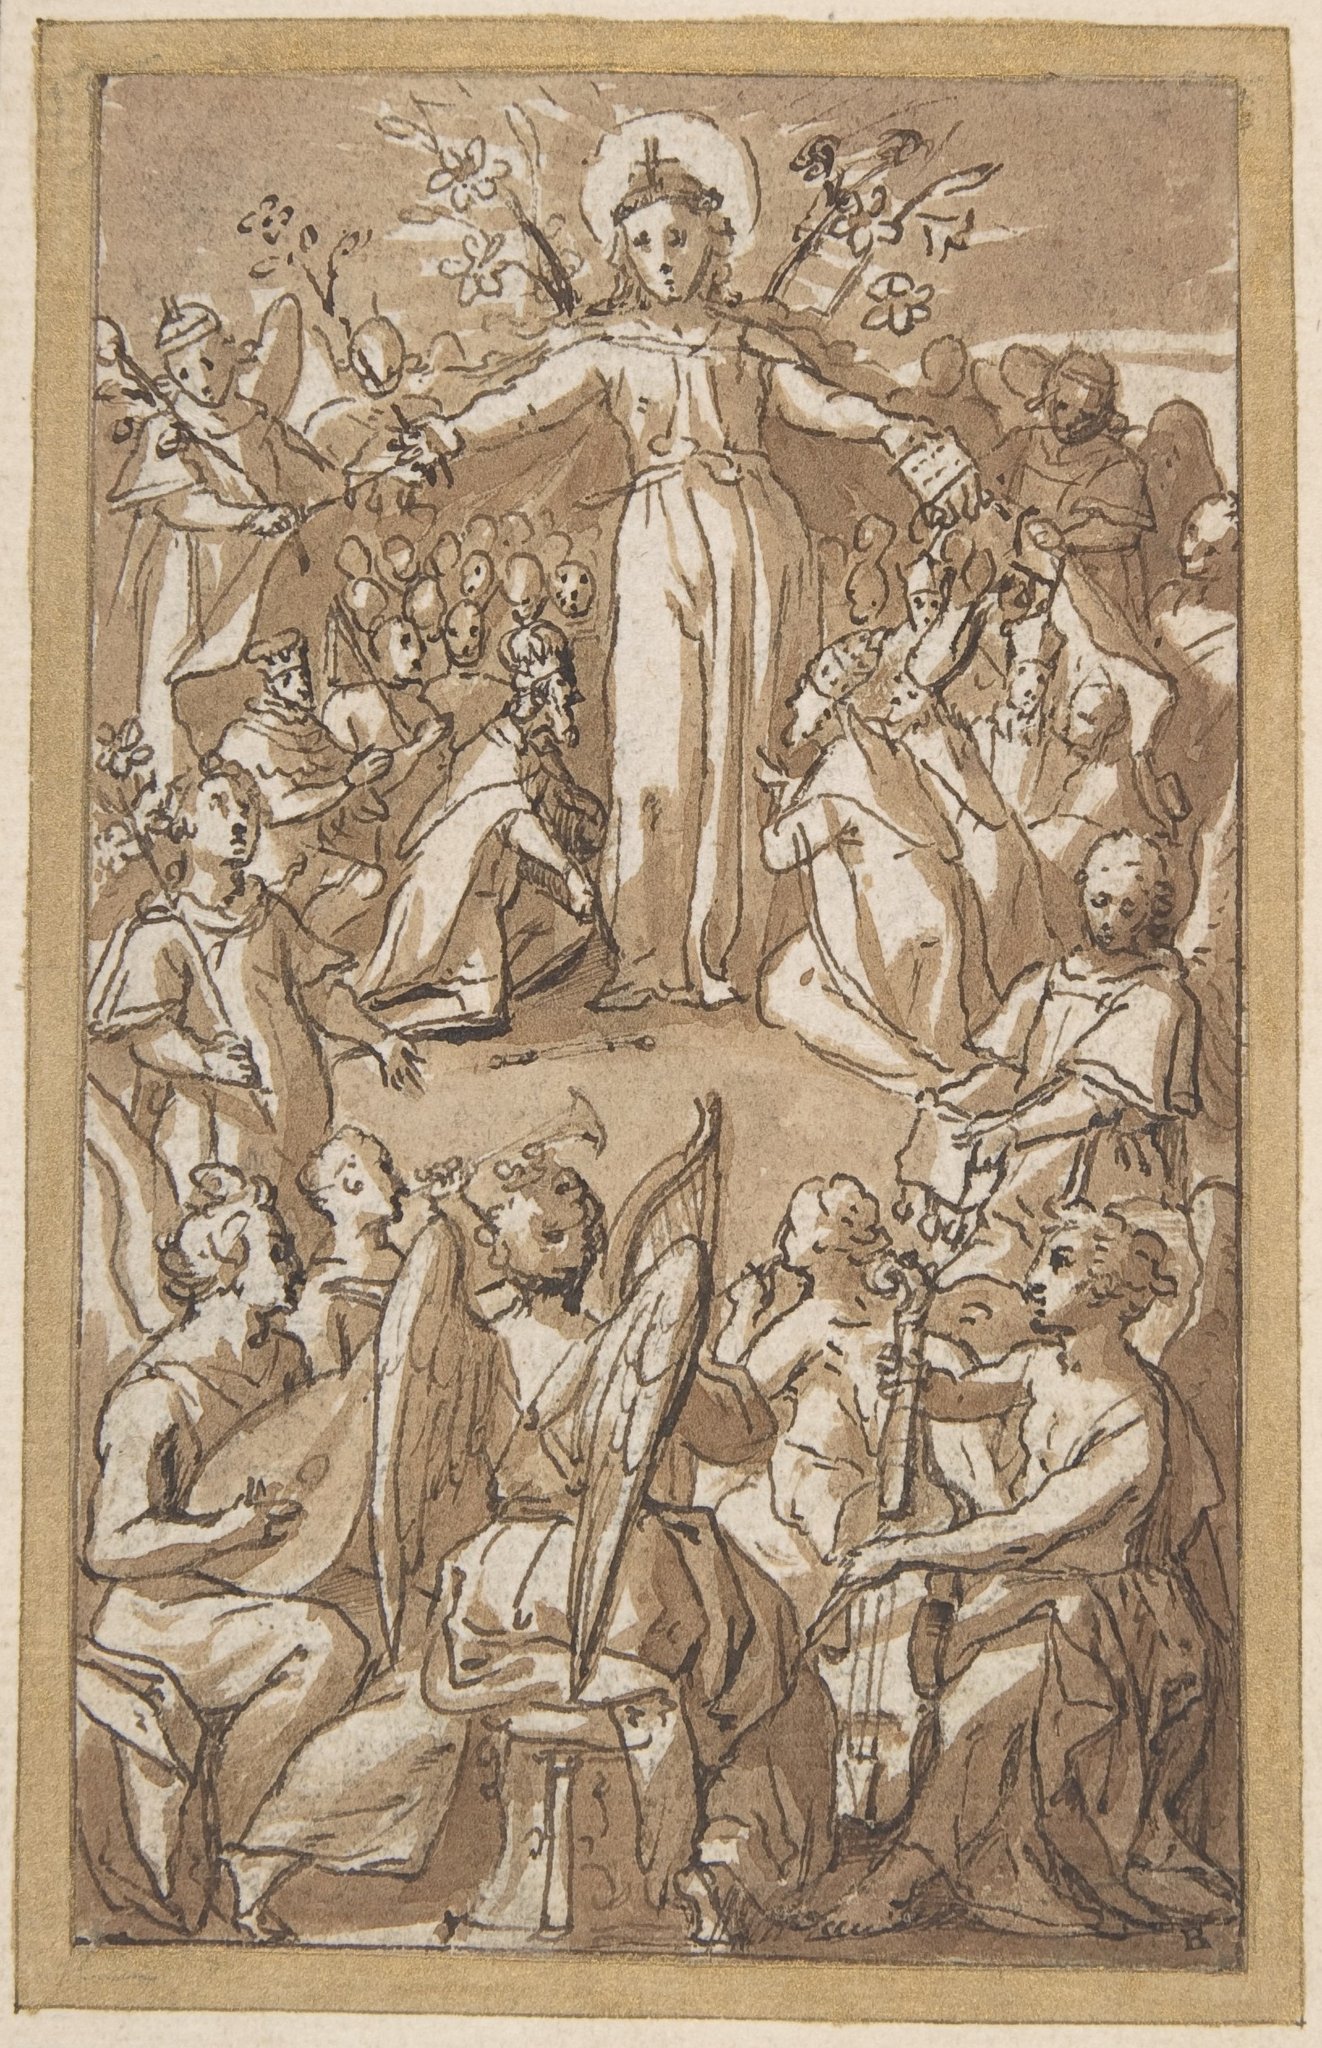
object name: drawing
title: The Virgin Surrounded by Angels and Representatives of Secular and Ecclesiastical Authorities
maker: pieter de jode (i)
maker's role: artist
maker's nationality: netherlandish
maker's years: 1570-1634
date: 1567-1666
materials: ink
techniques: brush, pen, transfer, wash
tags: musical instruments,angels,virgin mary